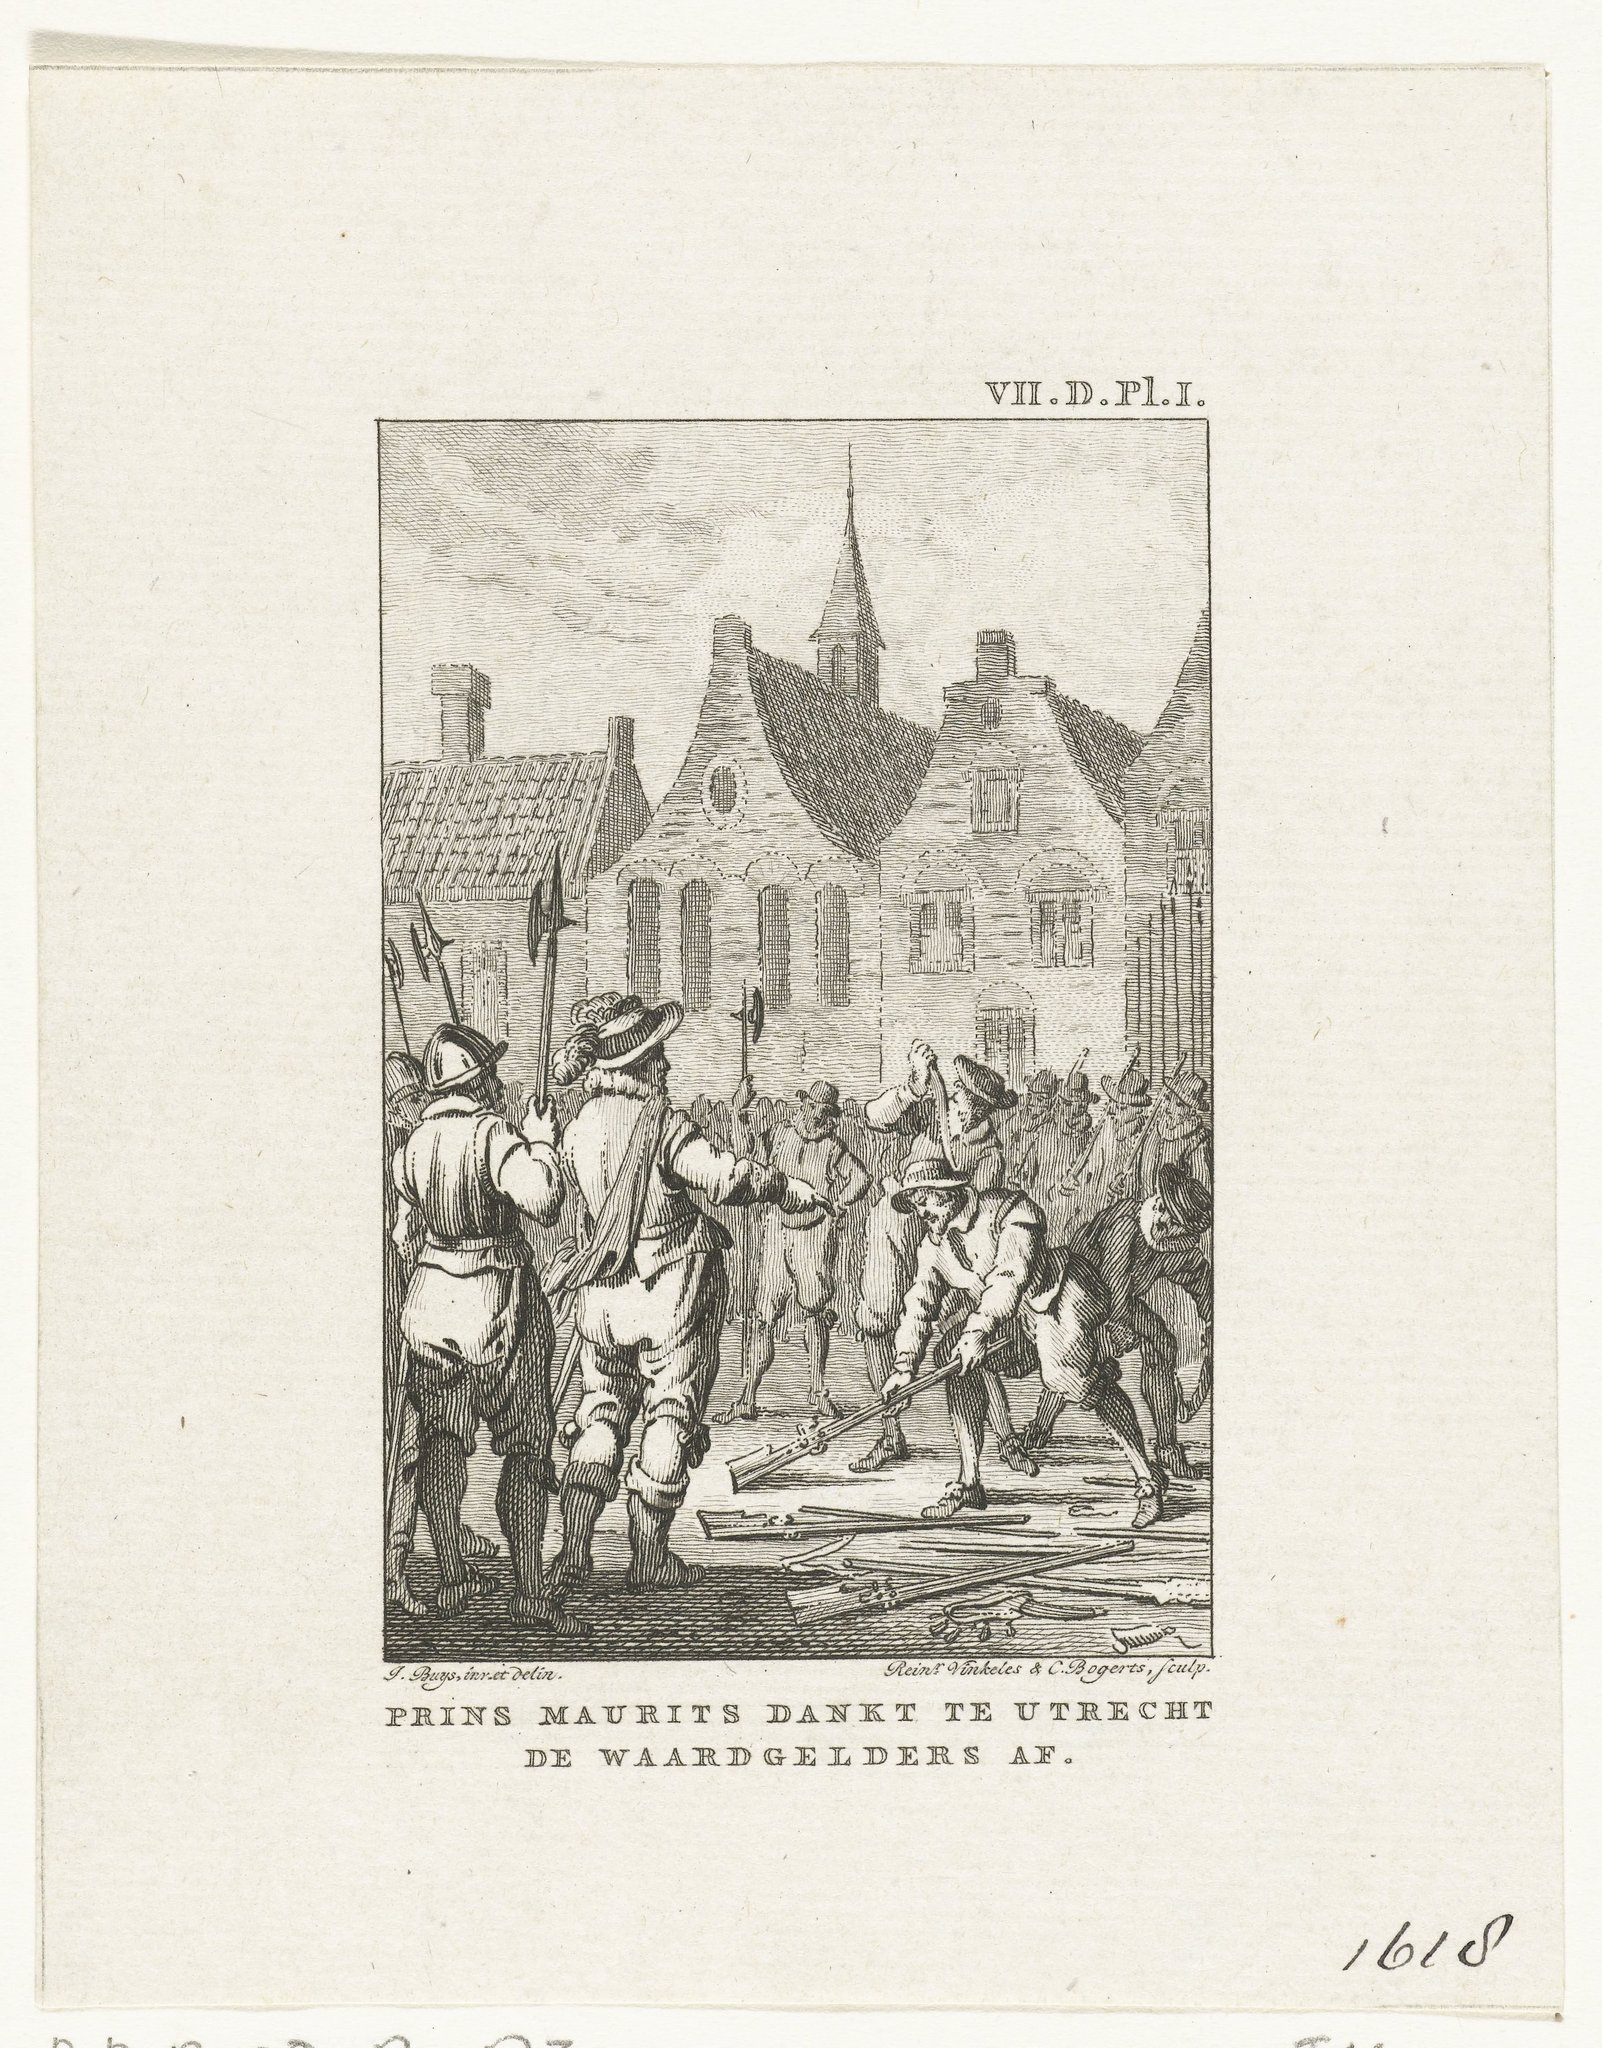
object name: history print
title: Het afdanken van de waardgelders te Utrecht, 1618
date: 1780-1795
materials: paper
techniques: etching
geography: netherlands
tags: the hague, maurice (prince of orange), demobilization, warfare; military affairs (+ mercenary troops, e.g.: lansquenets), assembling of military forces; mobilization, troop concentration, etc.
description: Gebruikt als illustratie in: J. Fokke, Geschiedenissen der Vereenigde Nederlanden voor de vaderlandsche jeugd, Johannes Allart, Amsterdam 1783-1795, 25 delen, dl. VII, pl. I.